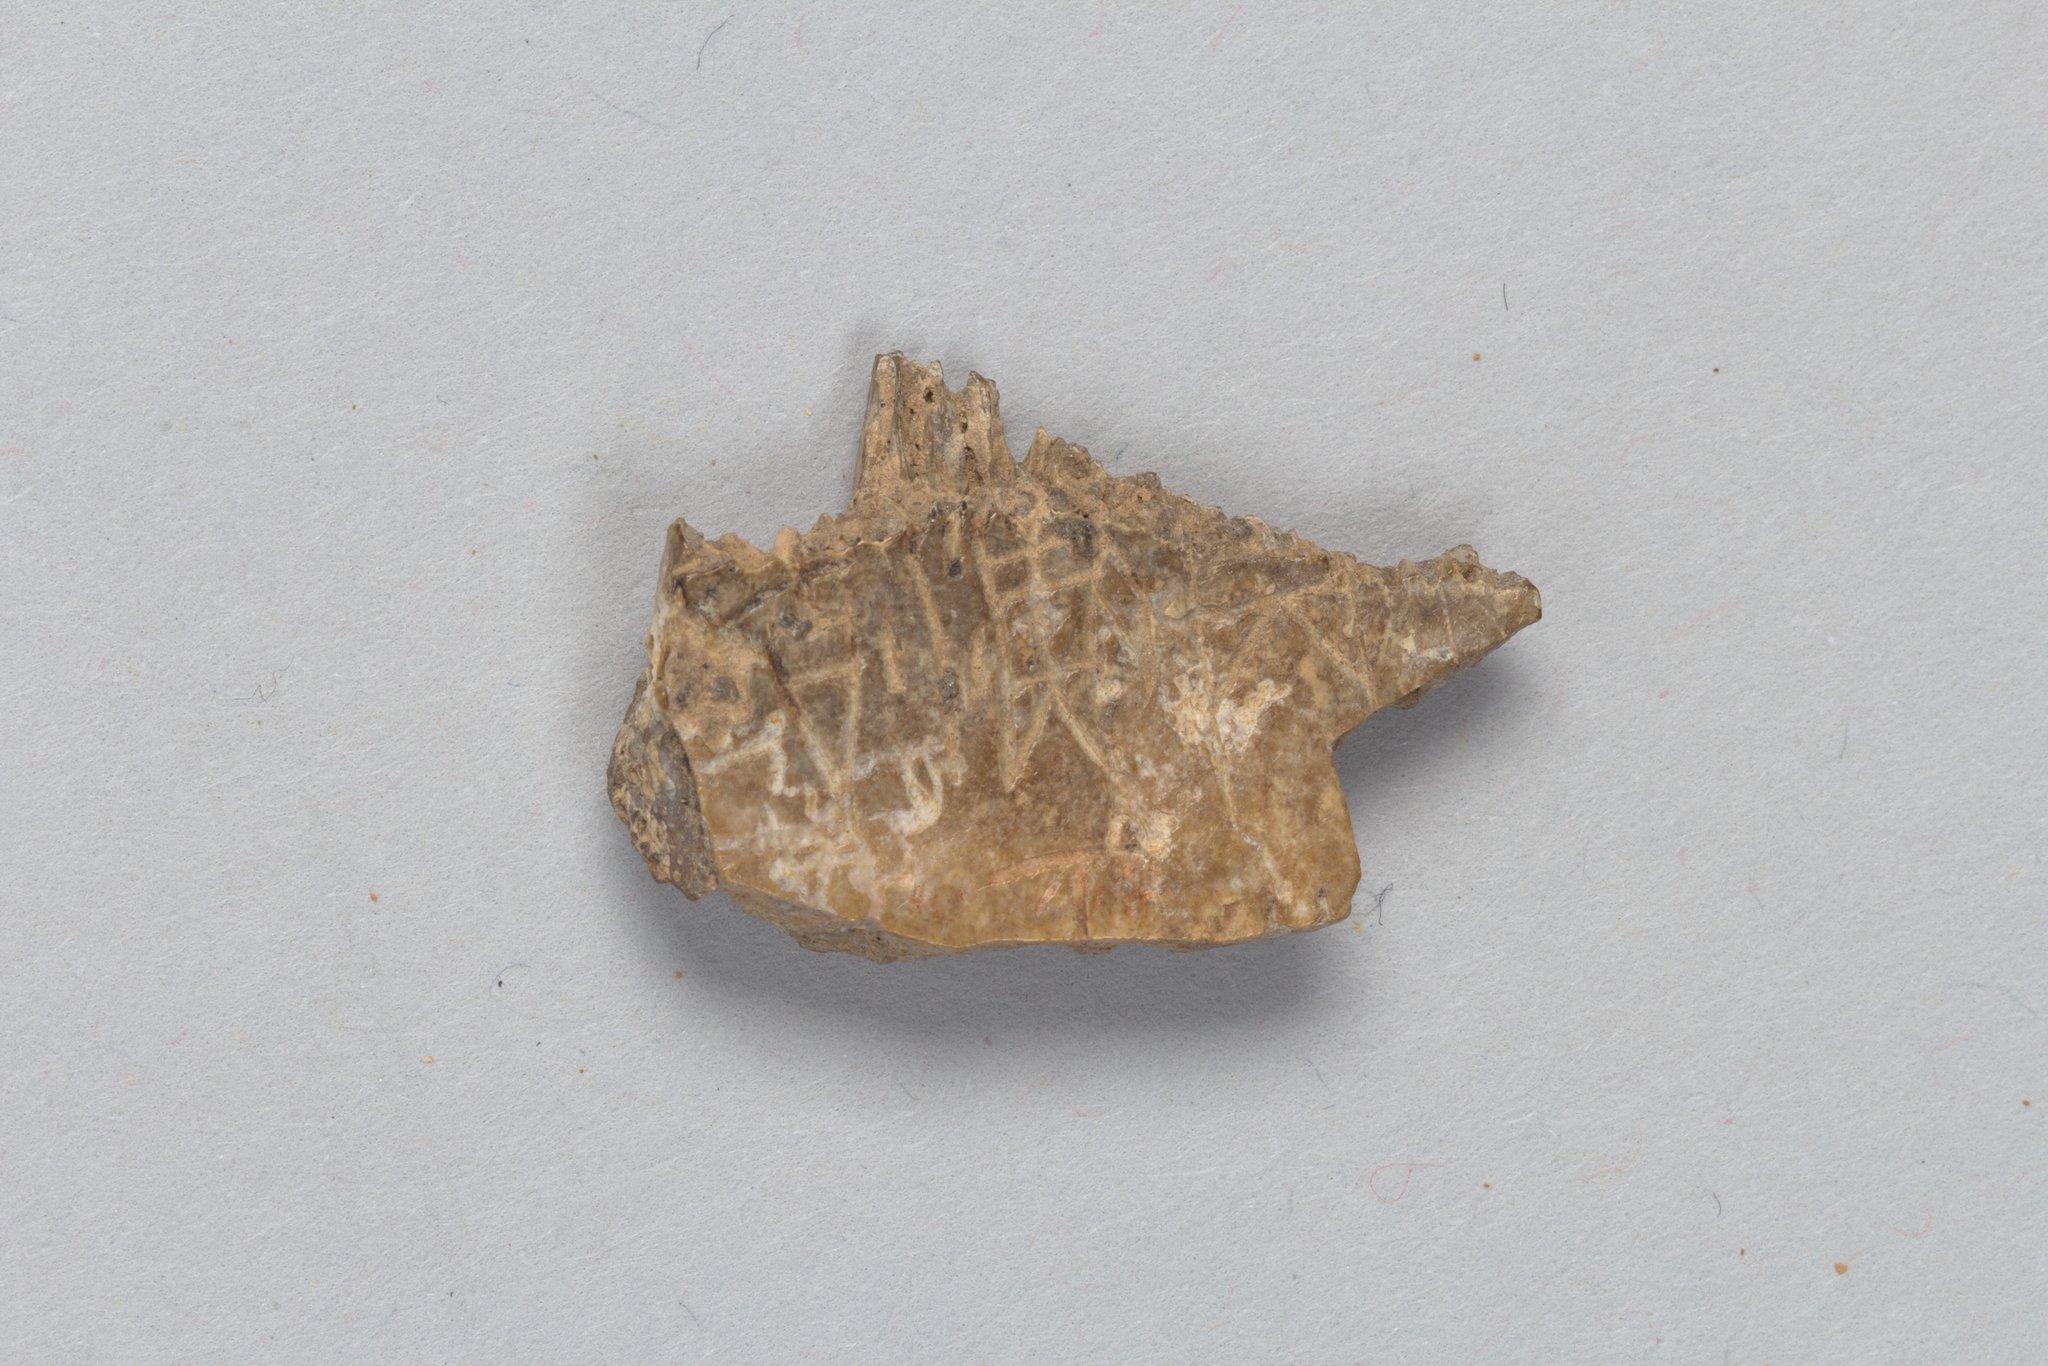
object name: oracle bone fragment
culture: chinese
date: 1600-1046 BCE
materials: bone